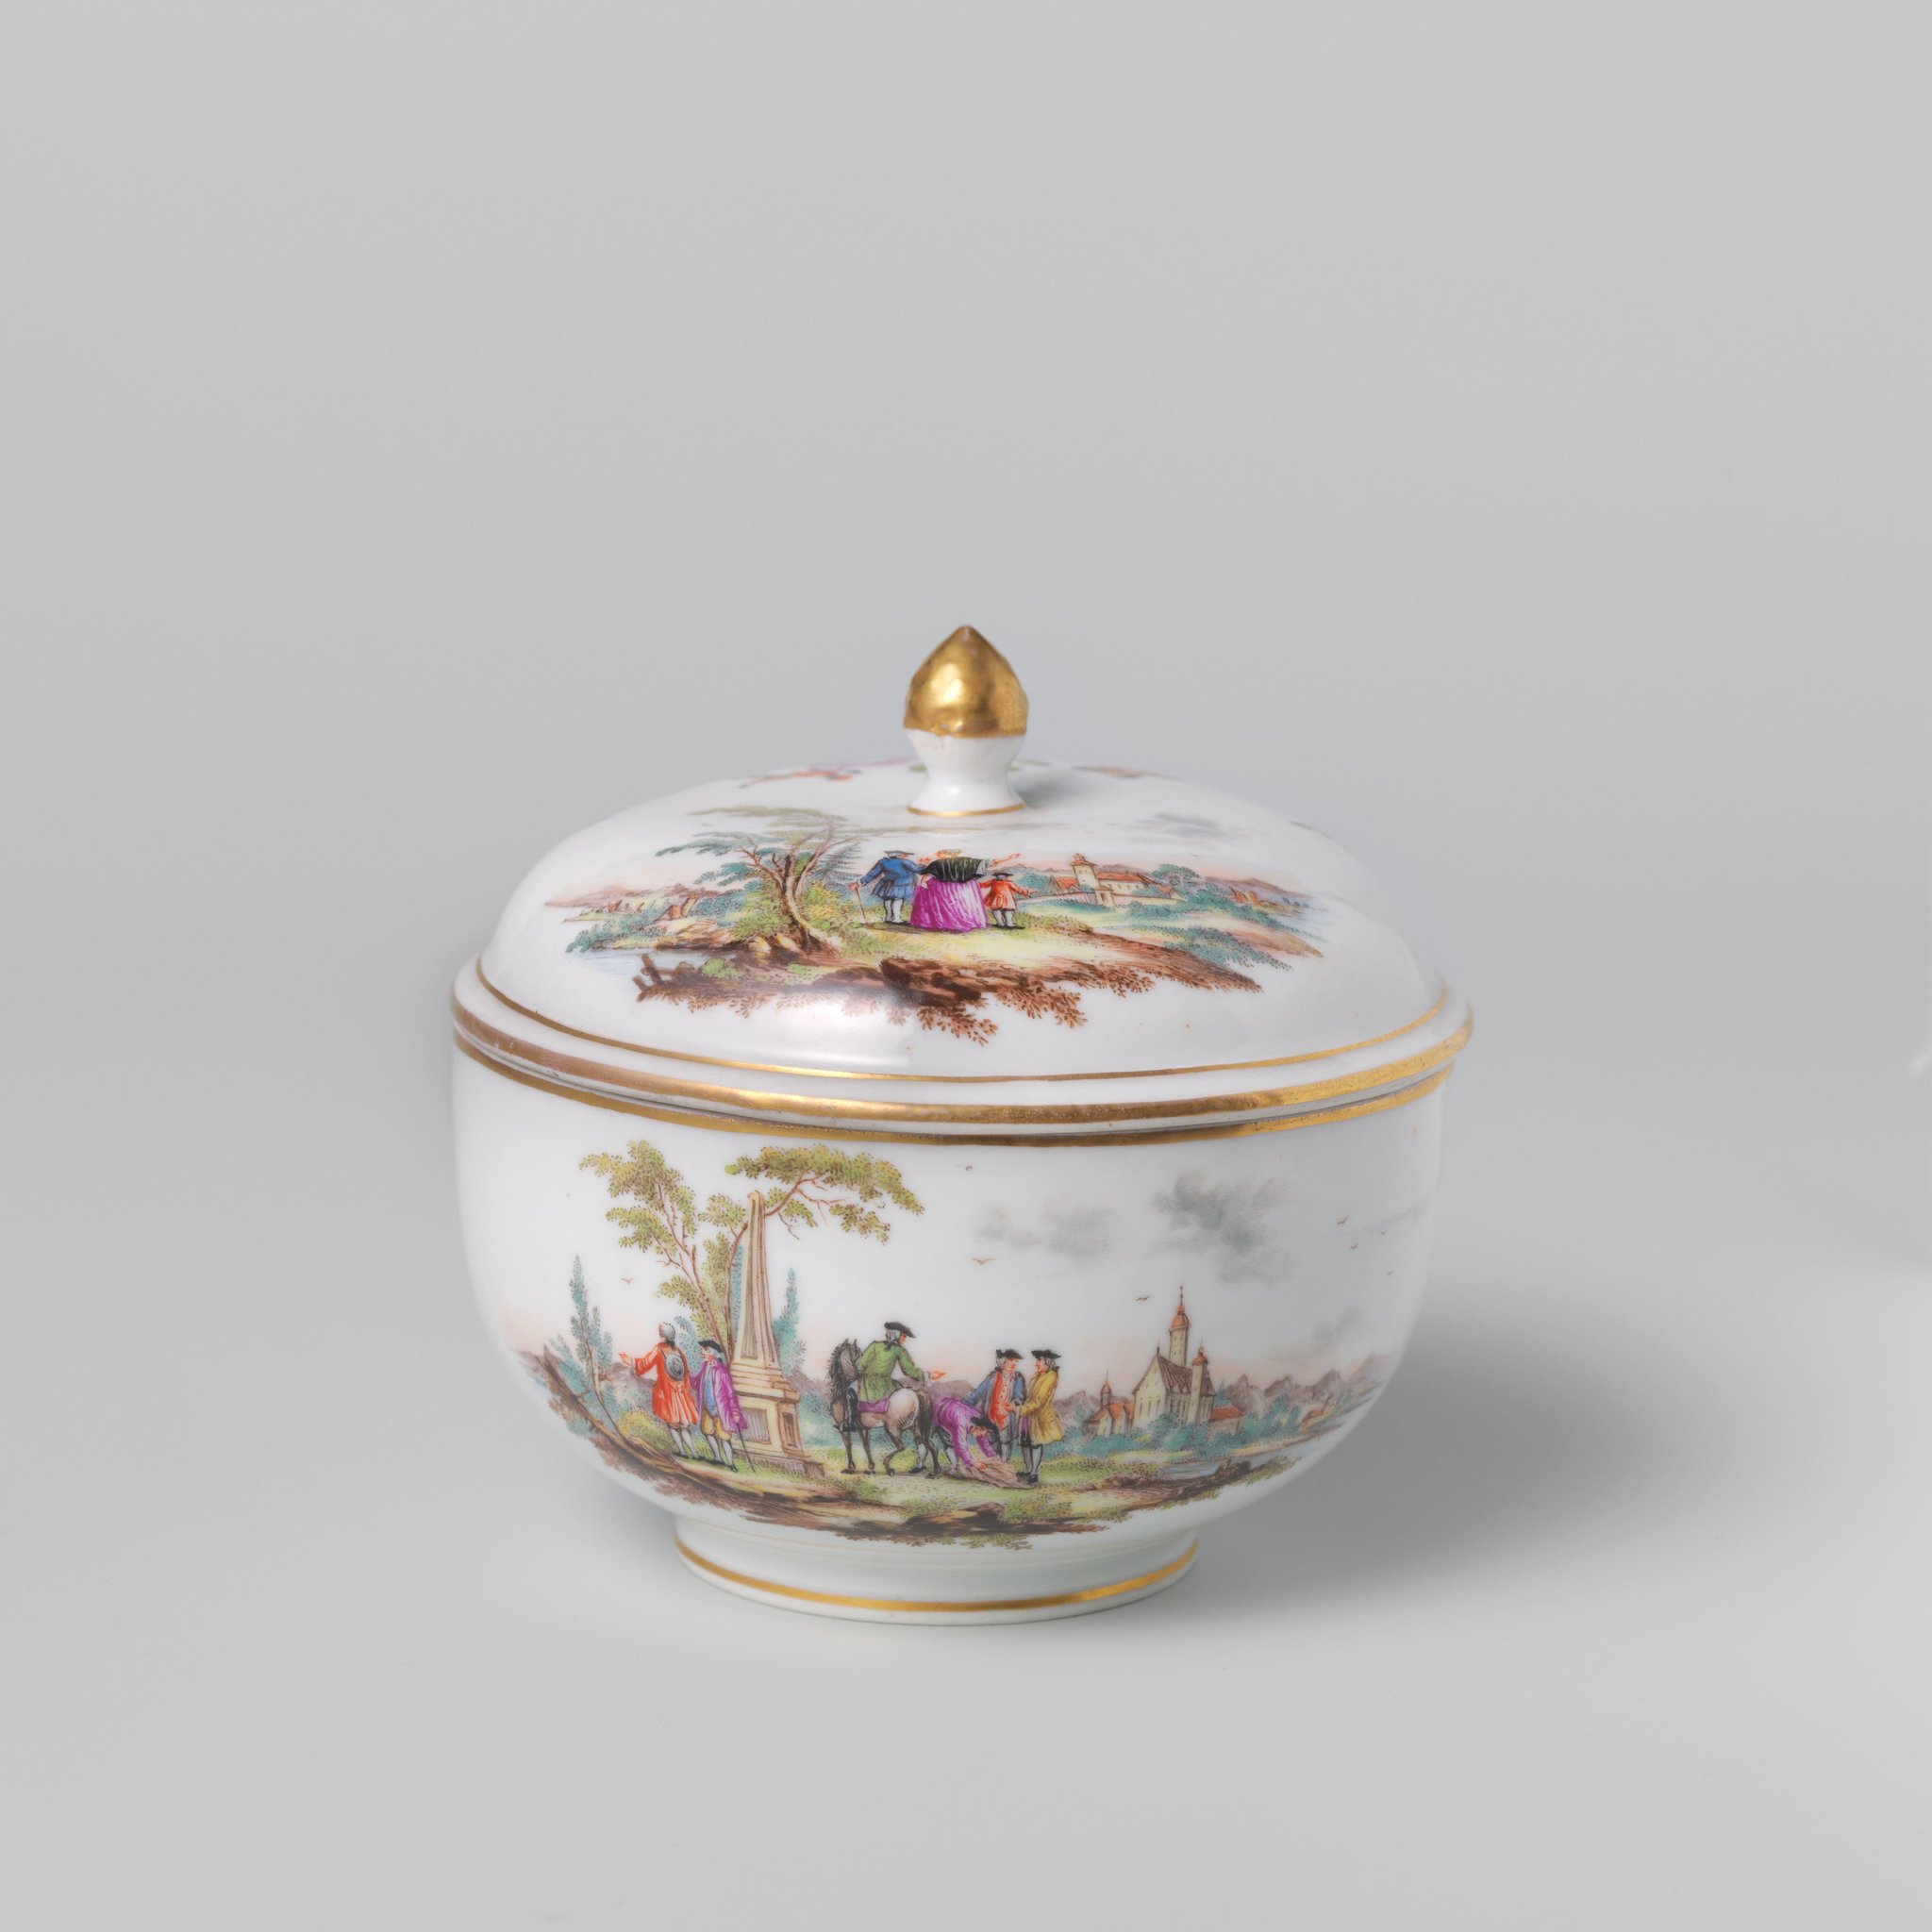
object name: tea service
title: Sugar bowl with a landscape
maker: Anonymous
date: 1765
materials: glaze, gold, paint, porcelain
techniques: firing, forming, gilding, vitrification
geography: sint-petersburg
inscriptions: mark: ‘monogram’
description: Suikerpot van porselein, beschilderd op het glazuur in emailkleuren en goud. Op de buitenwand een landschap met mensen en een soort obelisk. De andere zijde met een boeket en strooibloemen. Gouden lijnen op de voet en de rand. De tuit eindigd in een dierenkop. Gemerkt met het monogram van Catherine II van Rusland. Mogelijk een 19e of 20e eeuwse vervalsing.